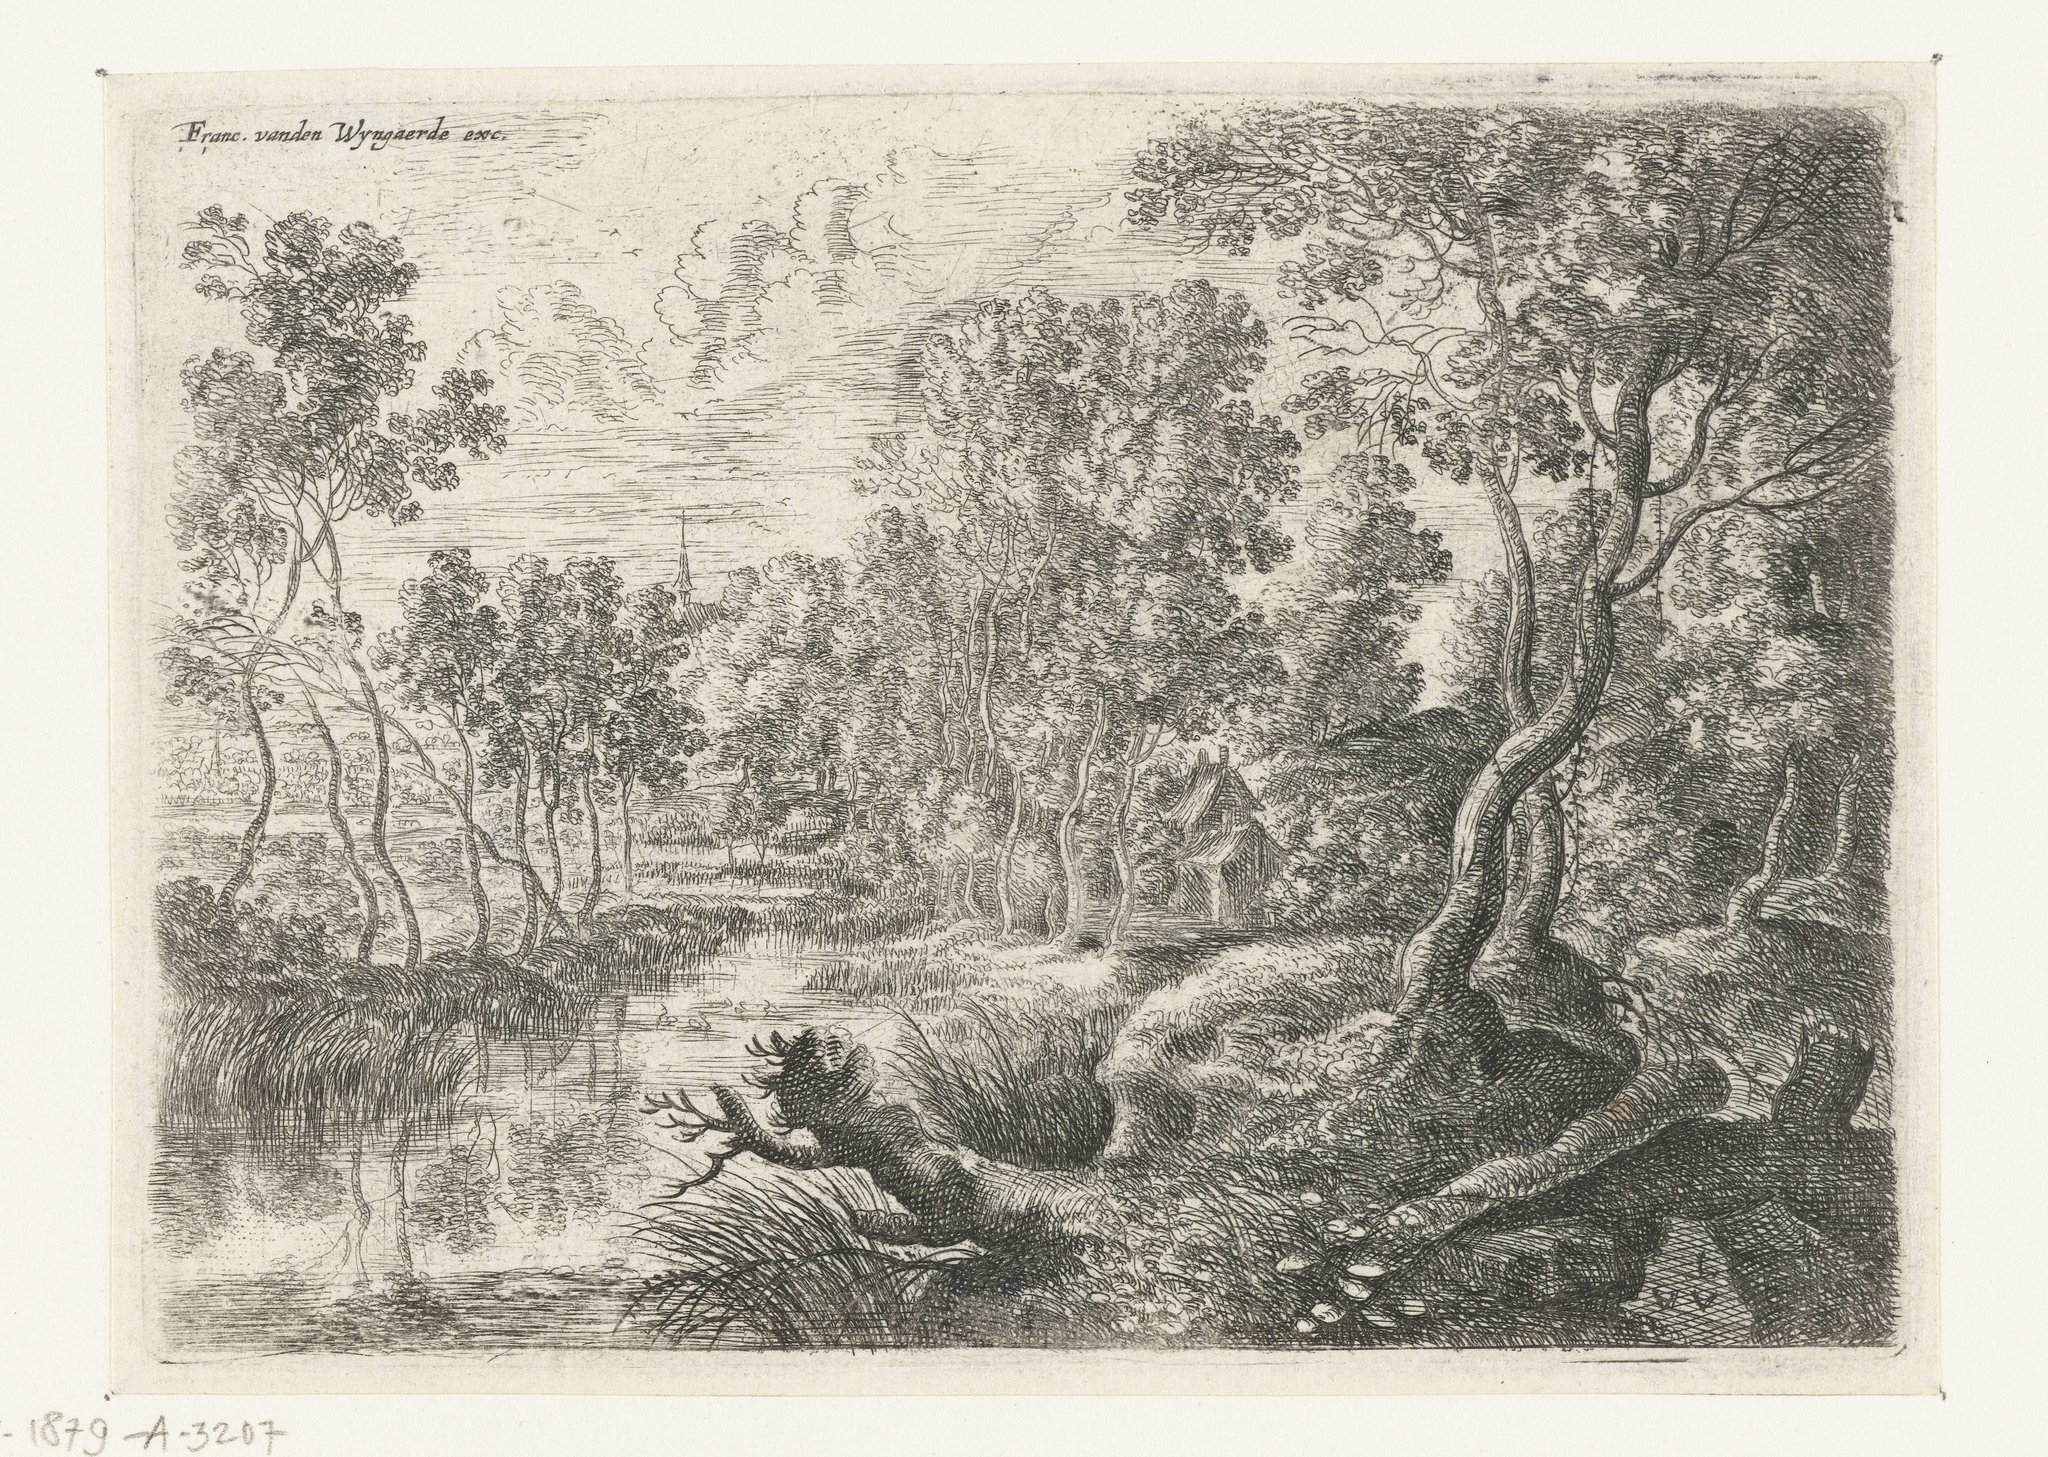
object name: print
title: Zes landschappen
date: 1605-1673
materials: paper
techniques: engraving, etching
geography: low countries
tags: brook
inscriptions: collector's mark: Lugt 2228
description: Uit een serie van zes. Landschap met een beek en in de verte een kerktoren.